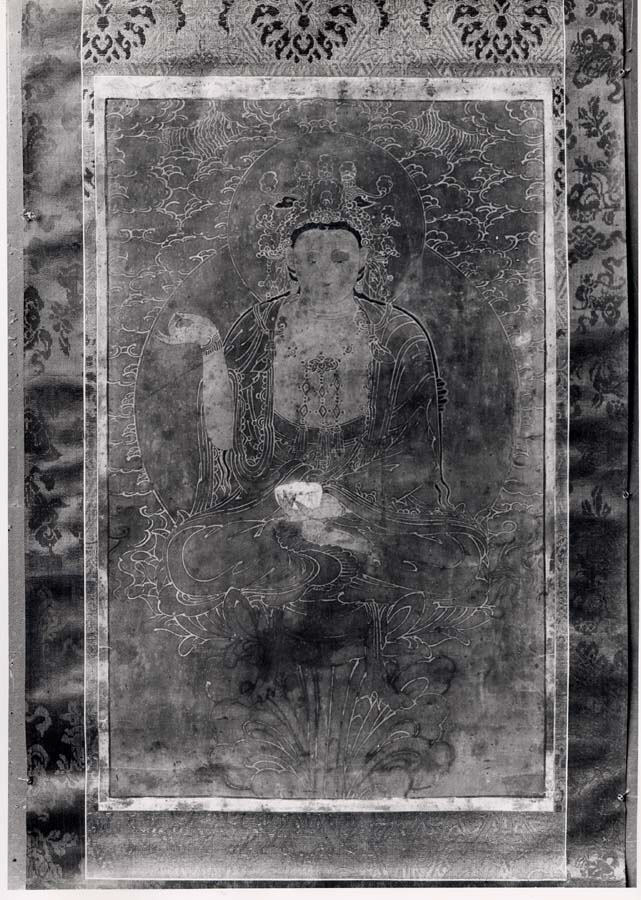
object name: hanging scroll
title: Bodhisattva with Double Halo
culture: korean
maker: unidentified artist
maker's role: artist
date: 1767-1833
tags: buddhism,bodhisattvas